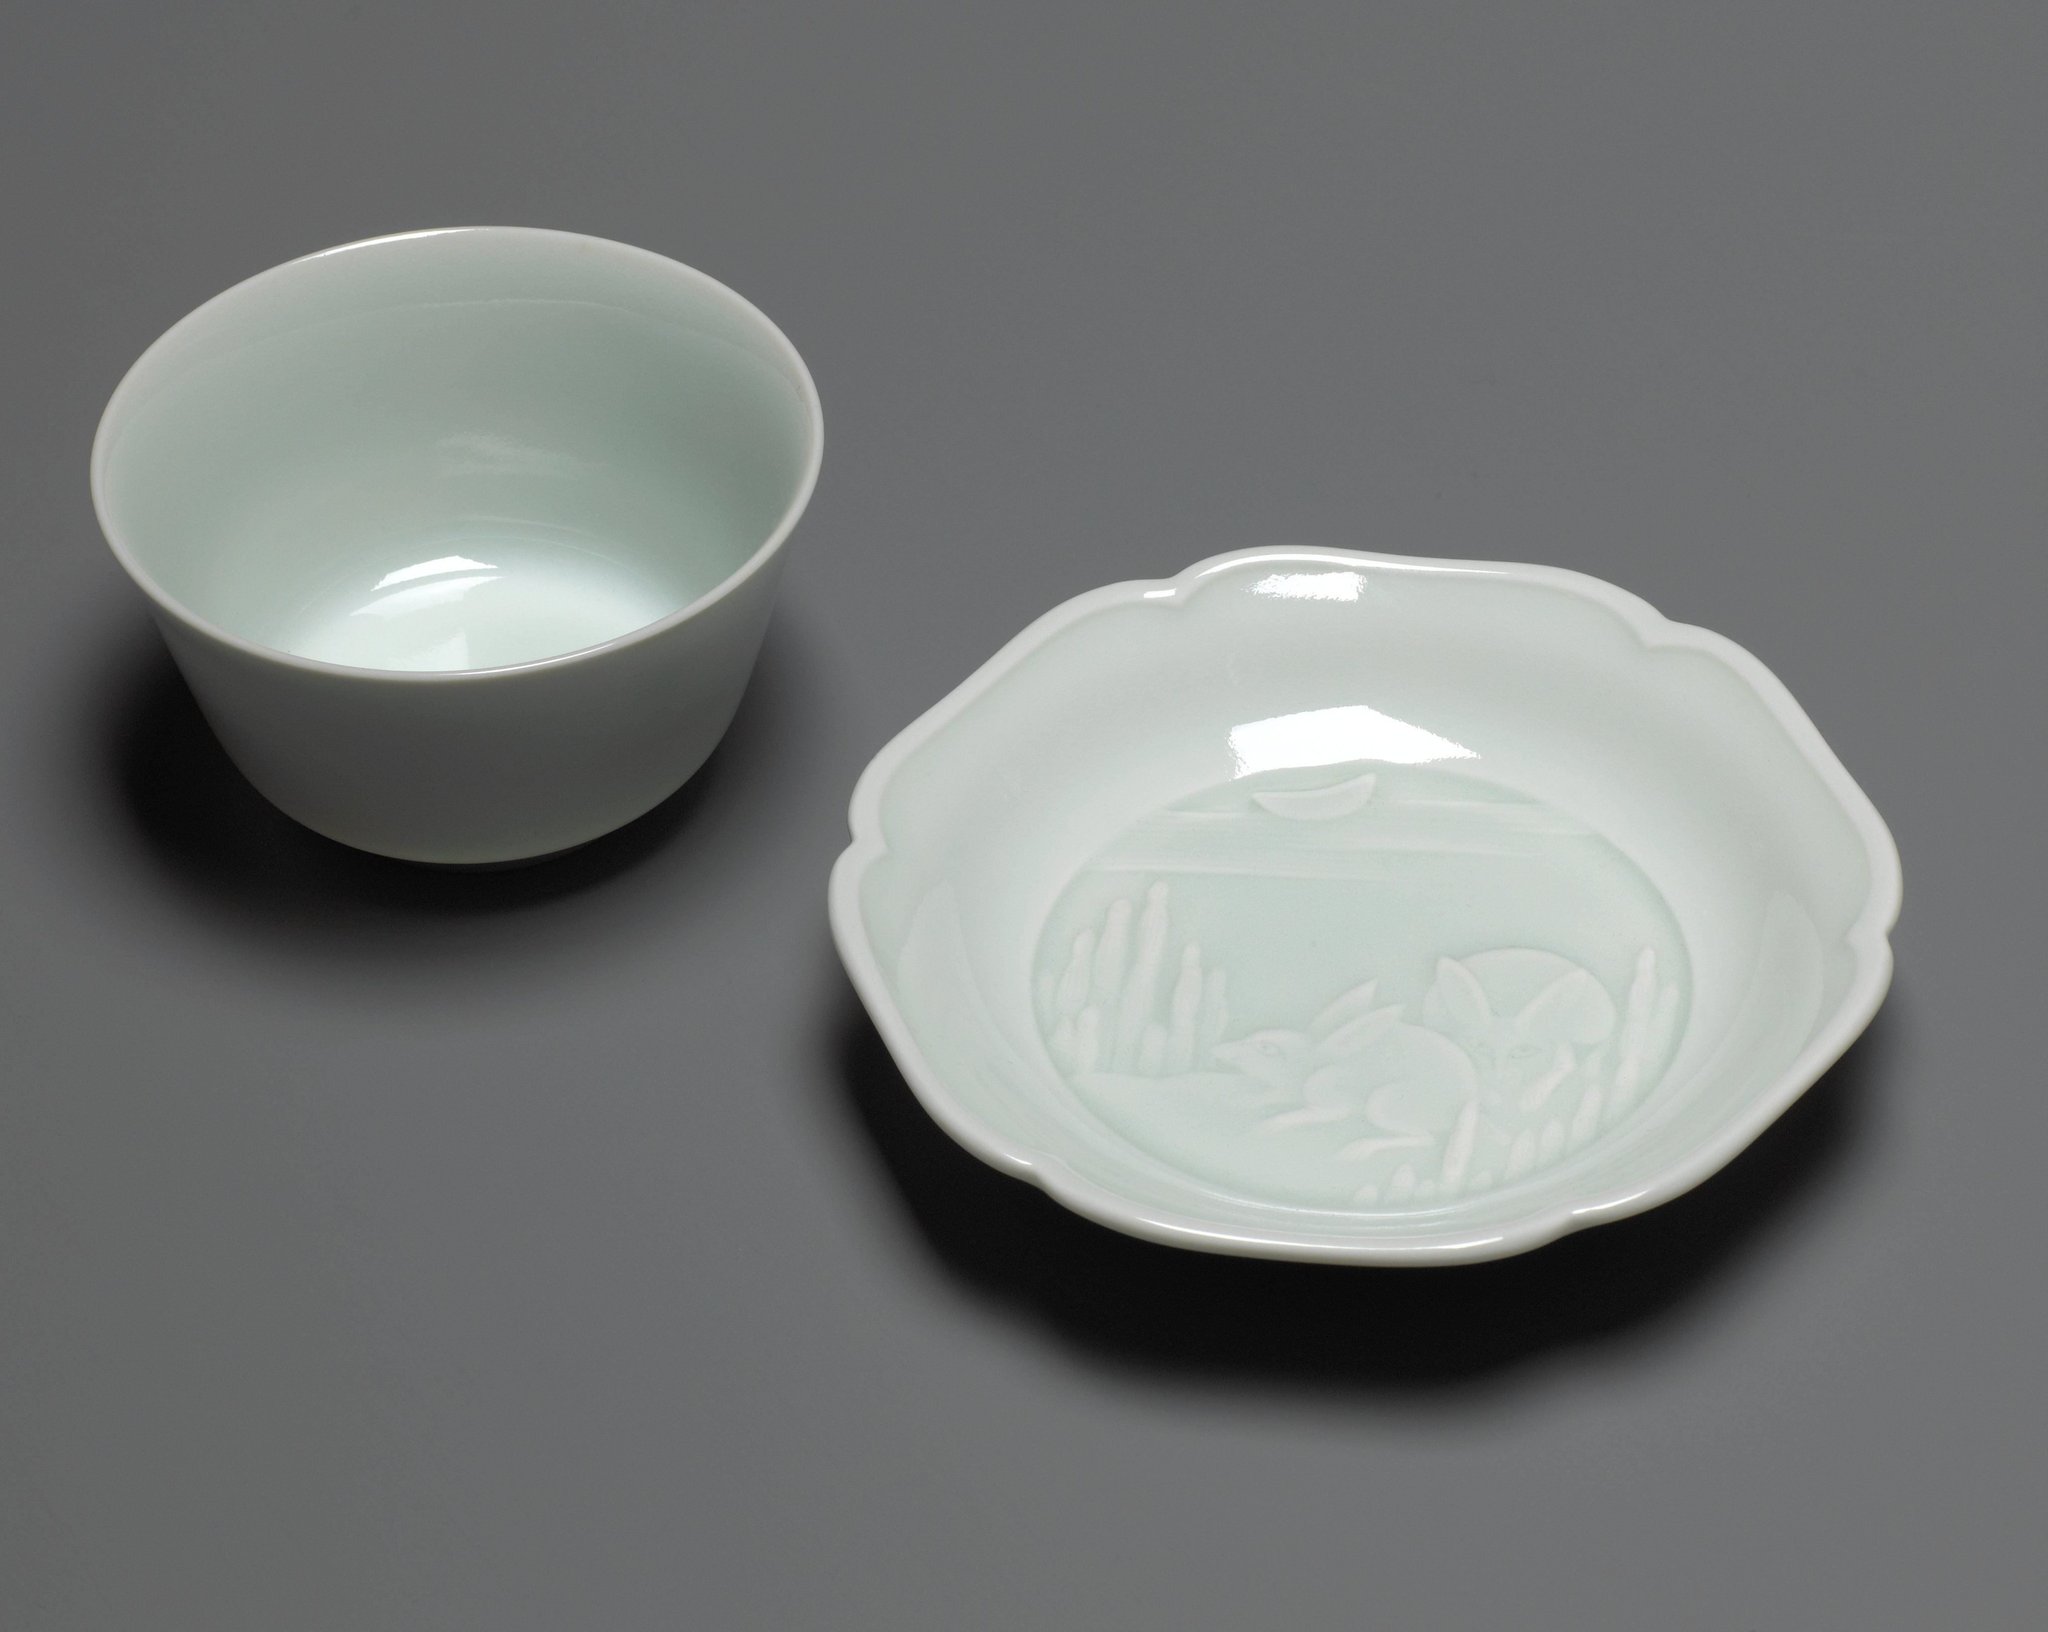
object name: kop en schotel, kop en schotel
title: Bell-shaped cup and saucer with two hares and the moon in relief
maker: masato imaizumi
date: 2002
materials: glaze, porcelain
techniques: firing, relief, turning, vitrification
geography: japan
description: Klokvormige kop en een geschulpte schotel van porselein, bedekt met een celadongroen glazuur. Op het plat van de schotel in reliëf twee hazen in een landschap onder de maan tussen wolken. Op de bodem van de kop alleen de maan tussen wolken. Gemerkt op de onderzijde. Monochromen.